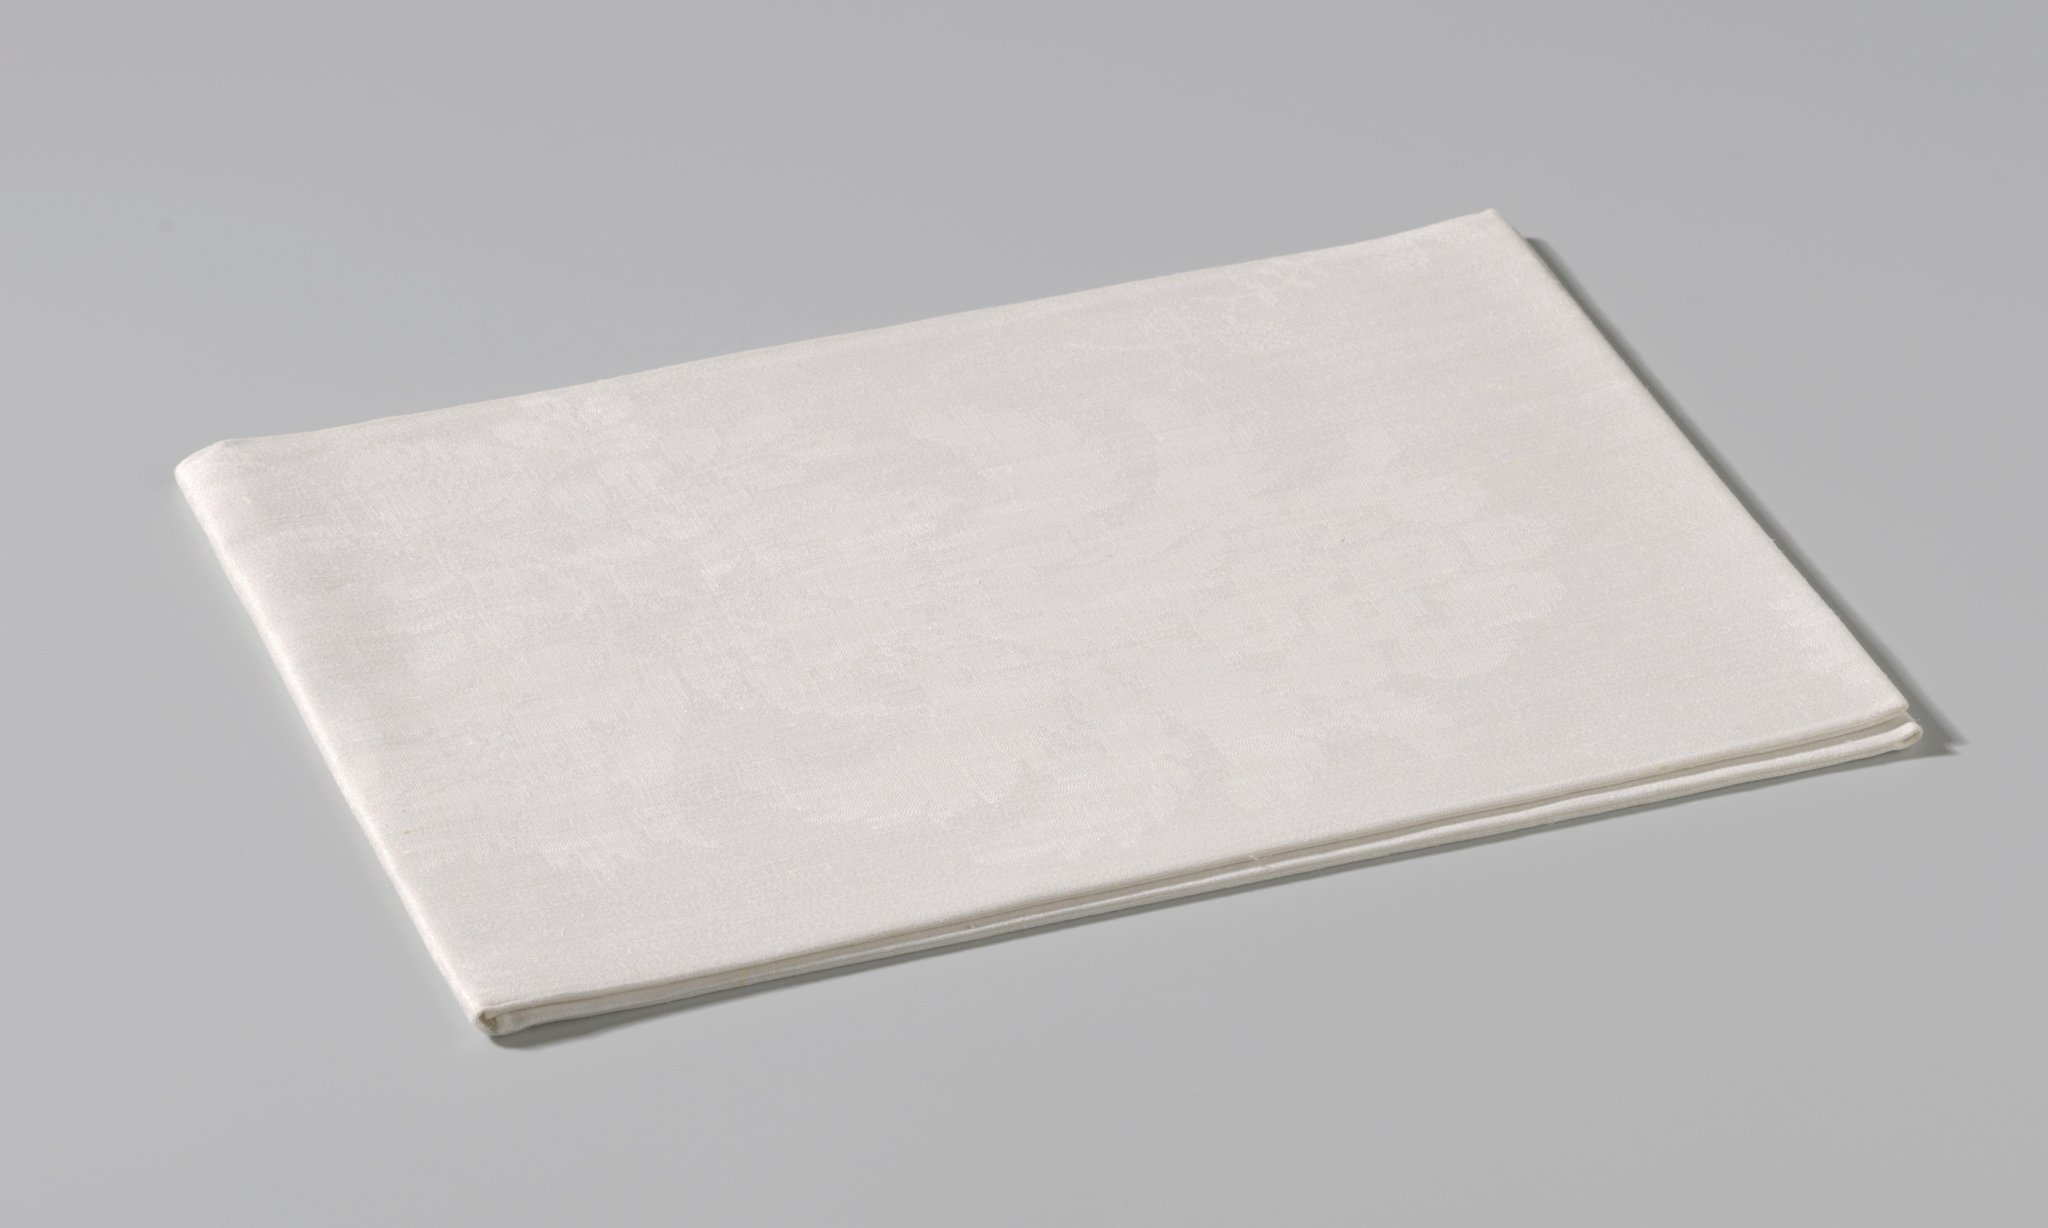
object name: napkin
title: Servet van linnendamast met een bloempatroon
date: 1740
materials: linen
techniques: damask, weave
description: Servet van linnendamast met een bloempatroon. Het servet hoort bij vijf servetten (BK-1973-177-A t/m BK-1973-177-F) en een tafellaken (BK-1973-176).